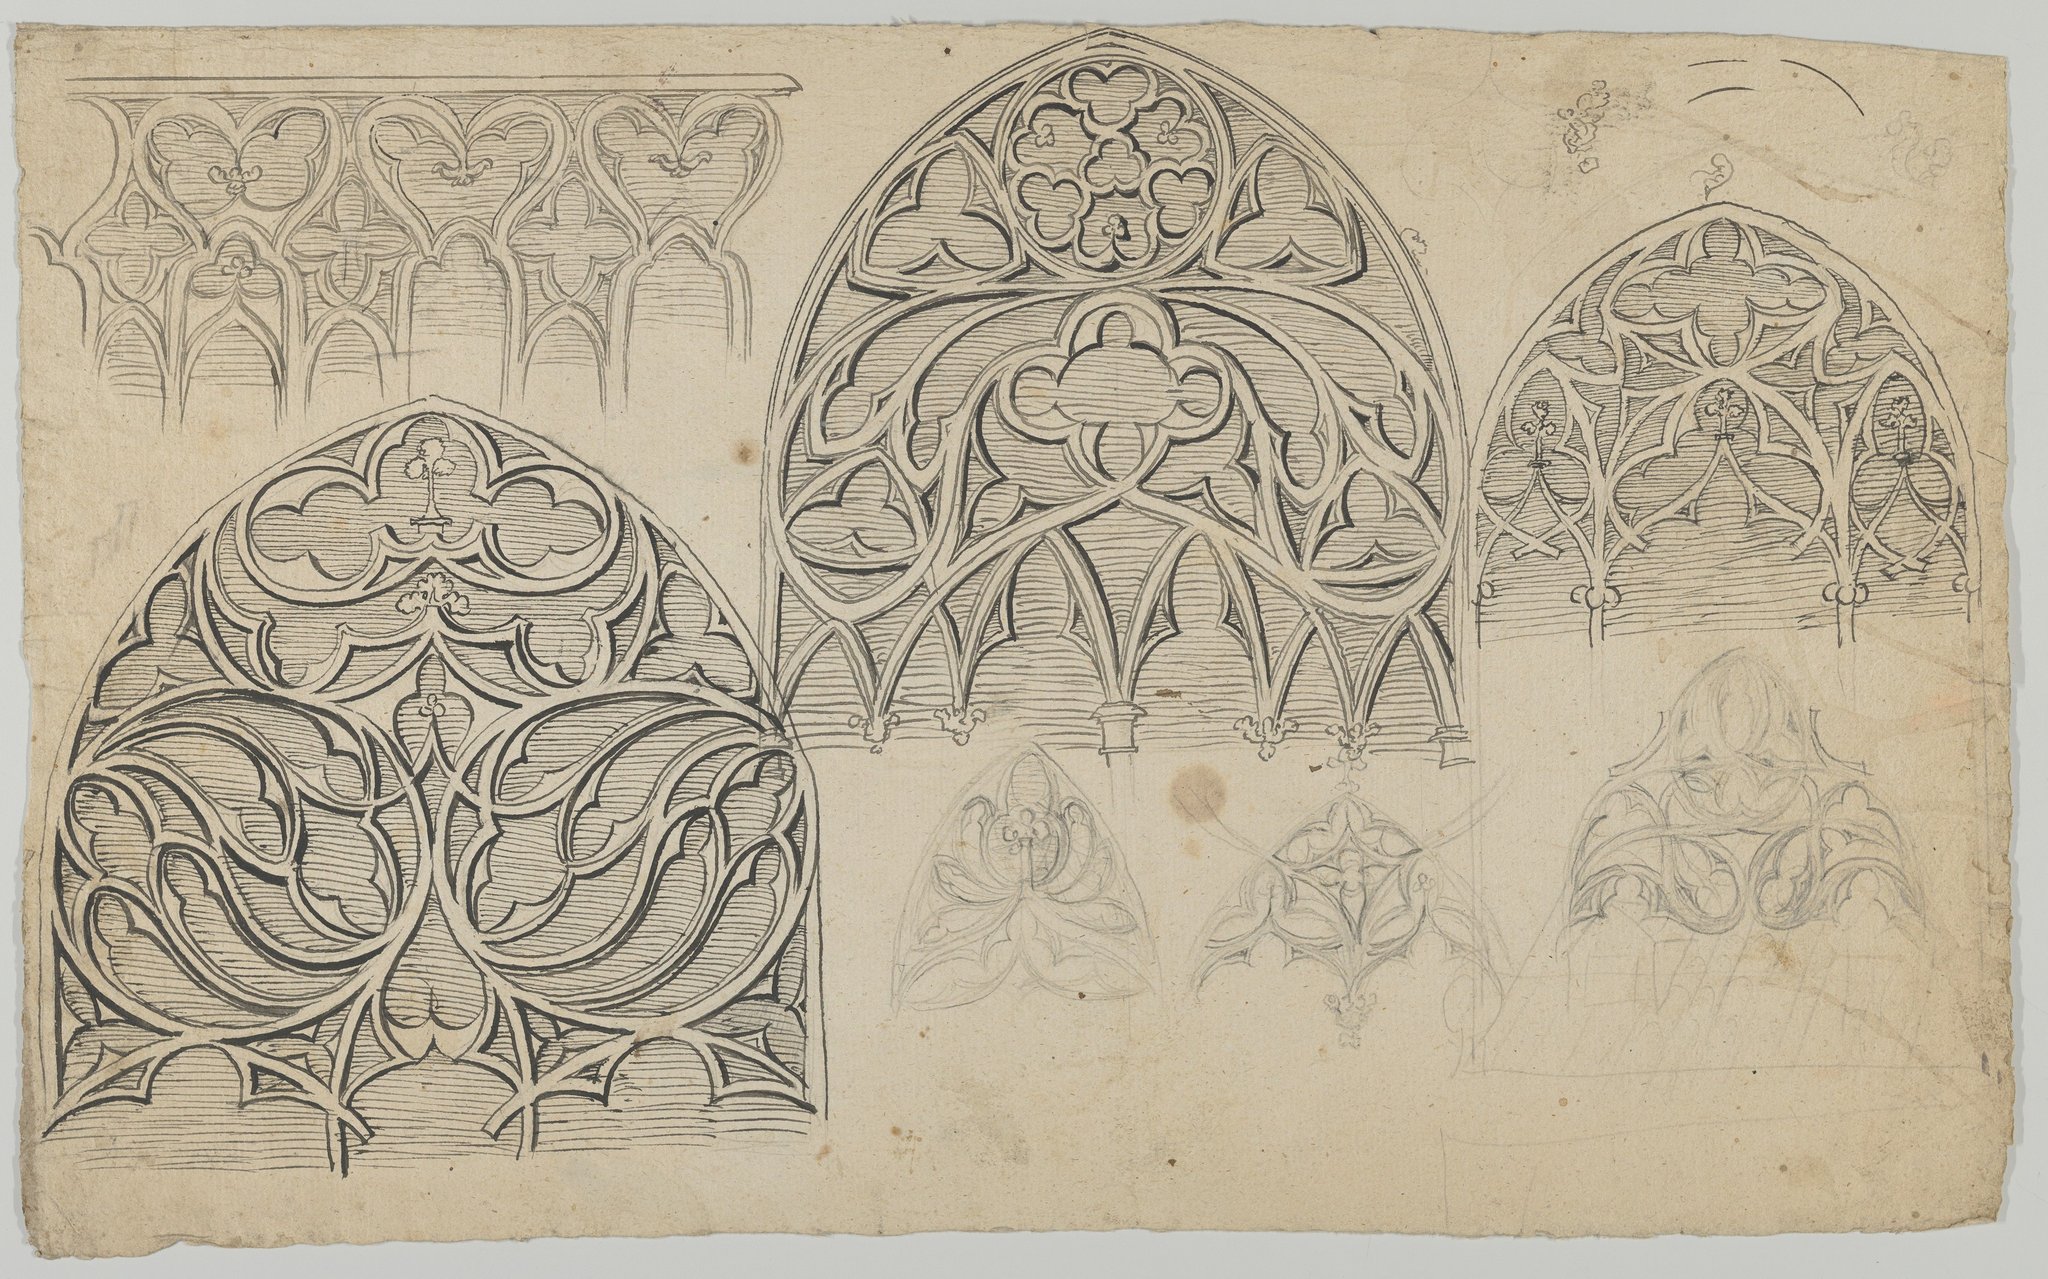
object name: drawing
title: Designs for Gothic tracery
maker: Anonymous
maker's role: artist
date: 1805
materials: ink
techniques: pen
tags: ornament